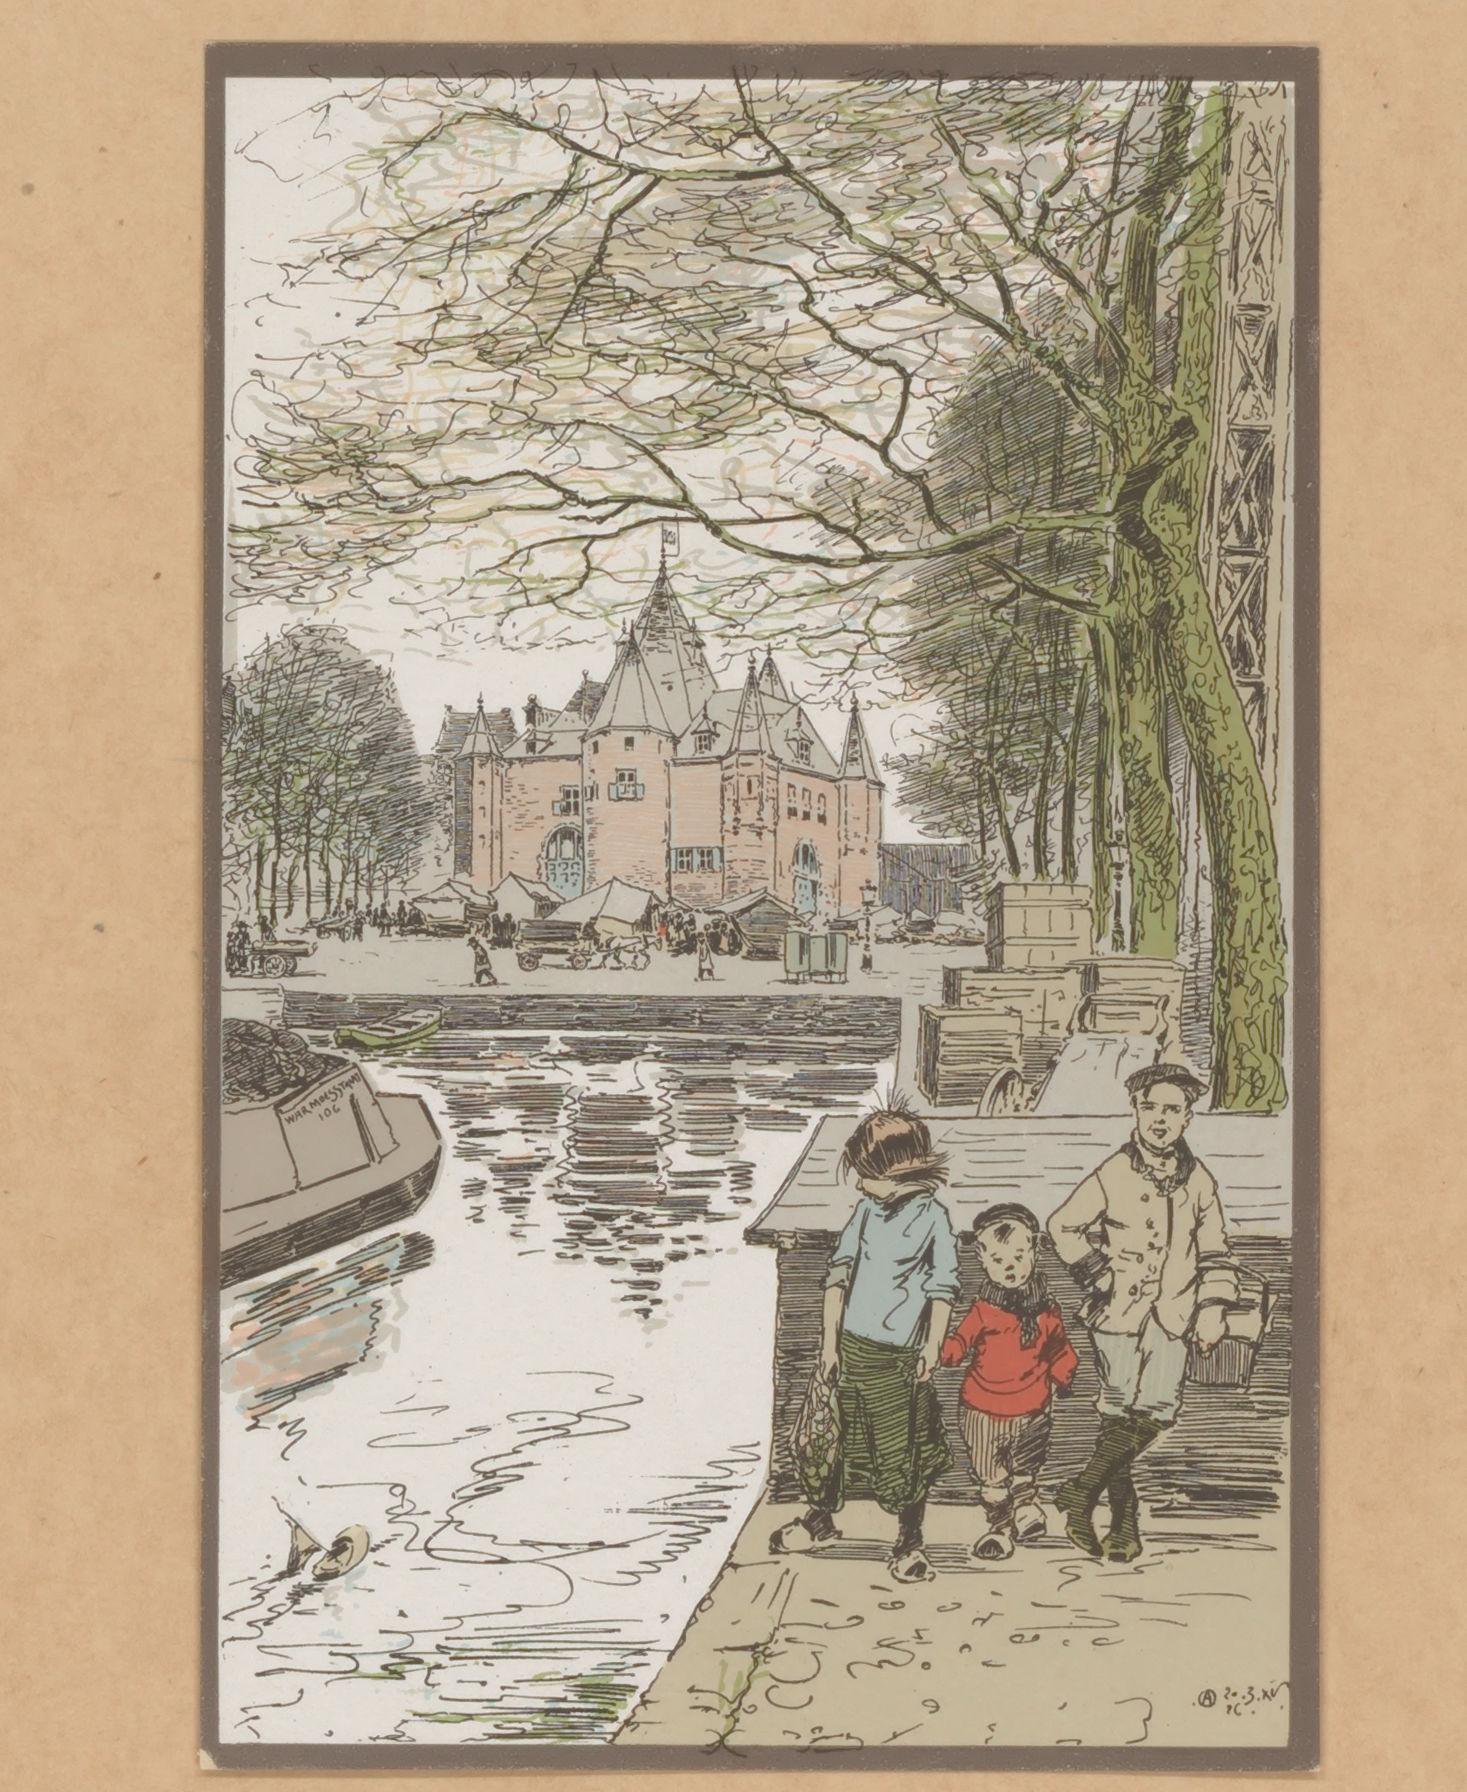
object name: photomechanical print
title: Gezicht op de Waag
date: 1915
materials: cardboard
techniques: line block, printing block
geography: utrecht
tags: city-view in general; 'veduta', canal, weigh-house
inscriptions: collector's mark: ‘3-46’ Lugt 1641b, signature: ‘A’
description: Onderwerpsrubriek binnen de Atlas Amsterdam: Panorama's en verzamelprenten.